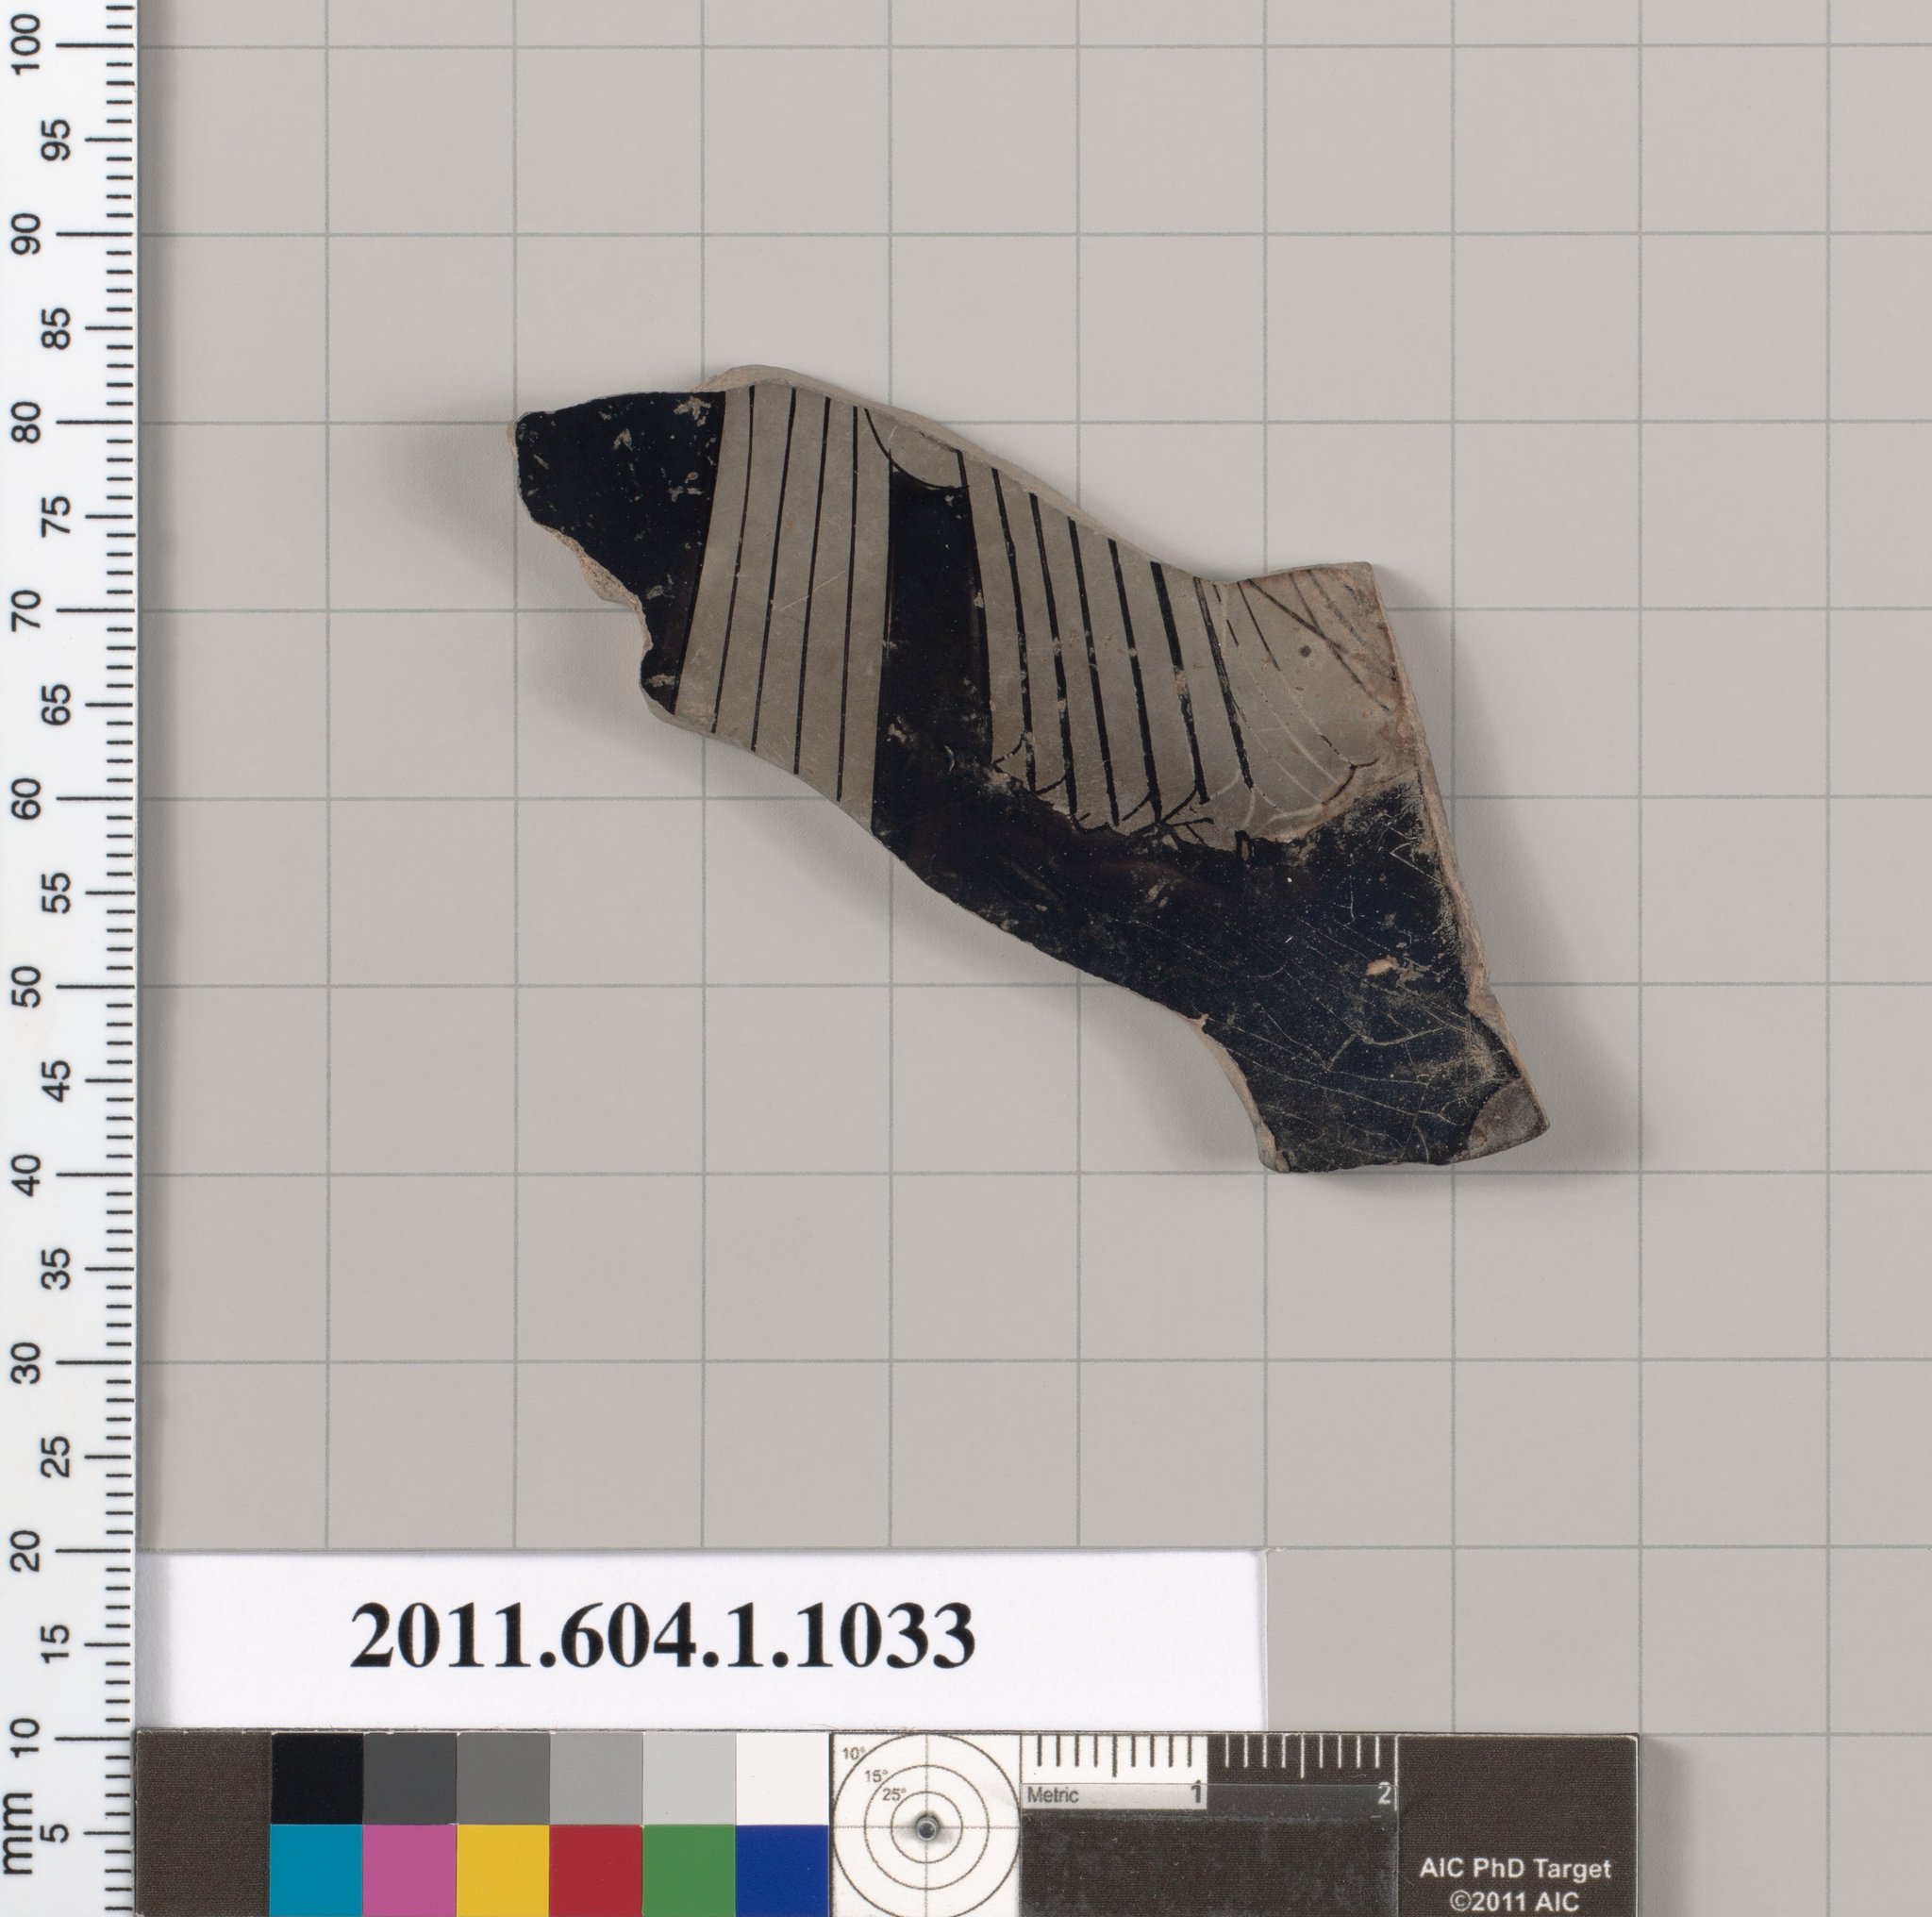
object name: kylix fragment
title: Terracotta fragment of a kylix (drinking cup)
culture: greek, attic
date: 490-480 BCE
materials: terracotta